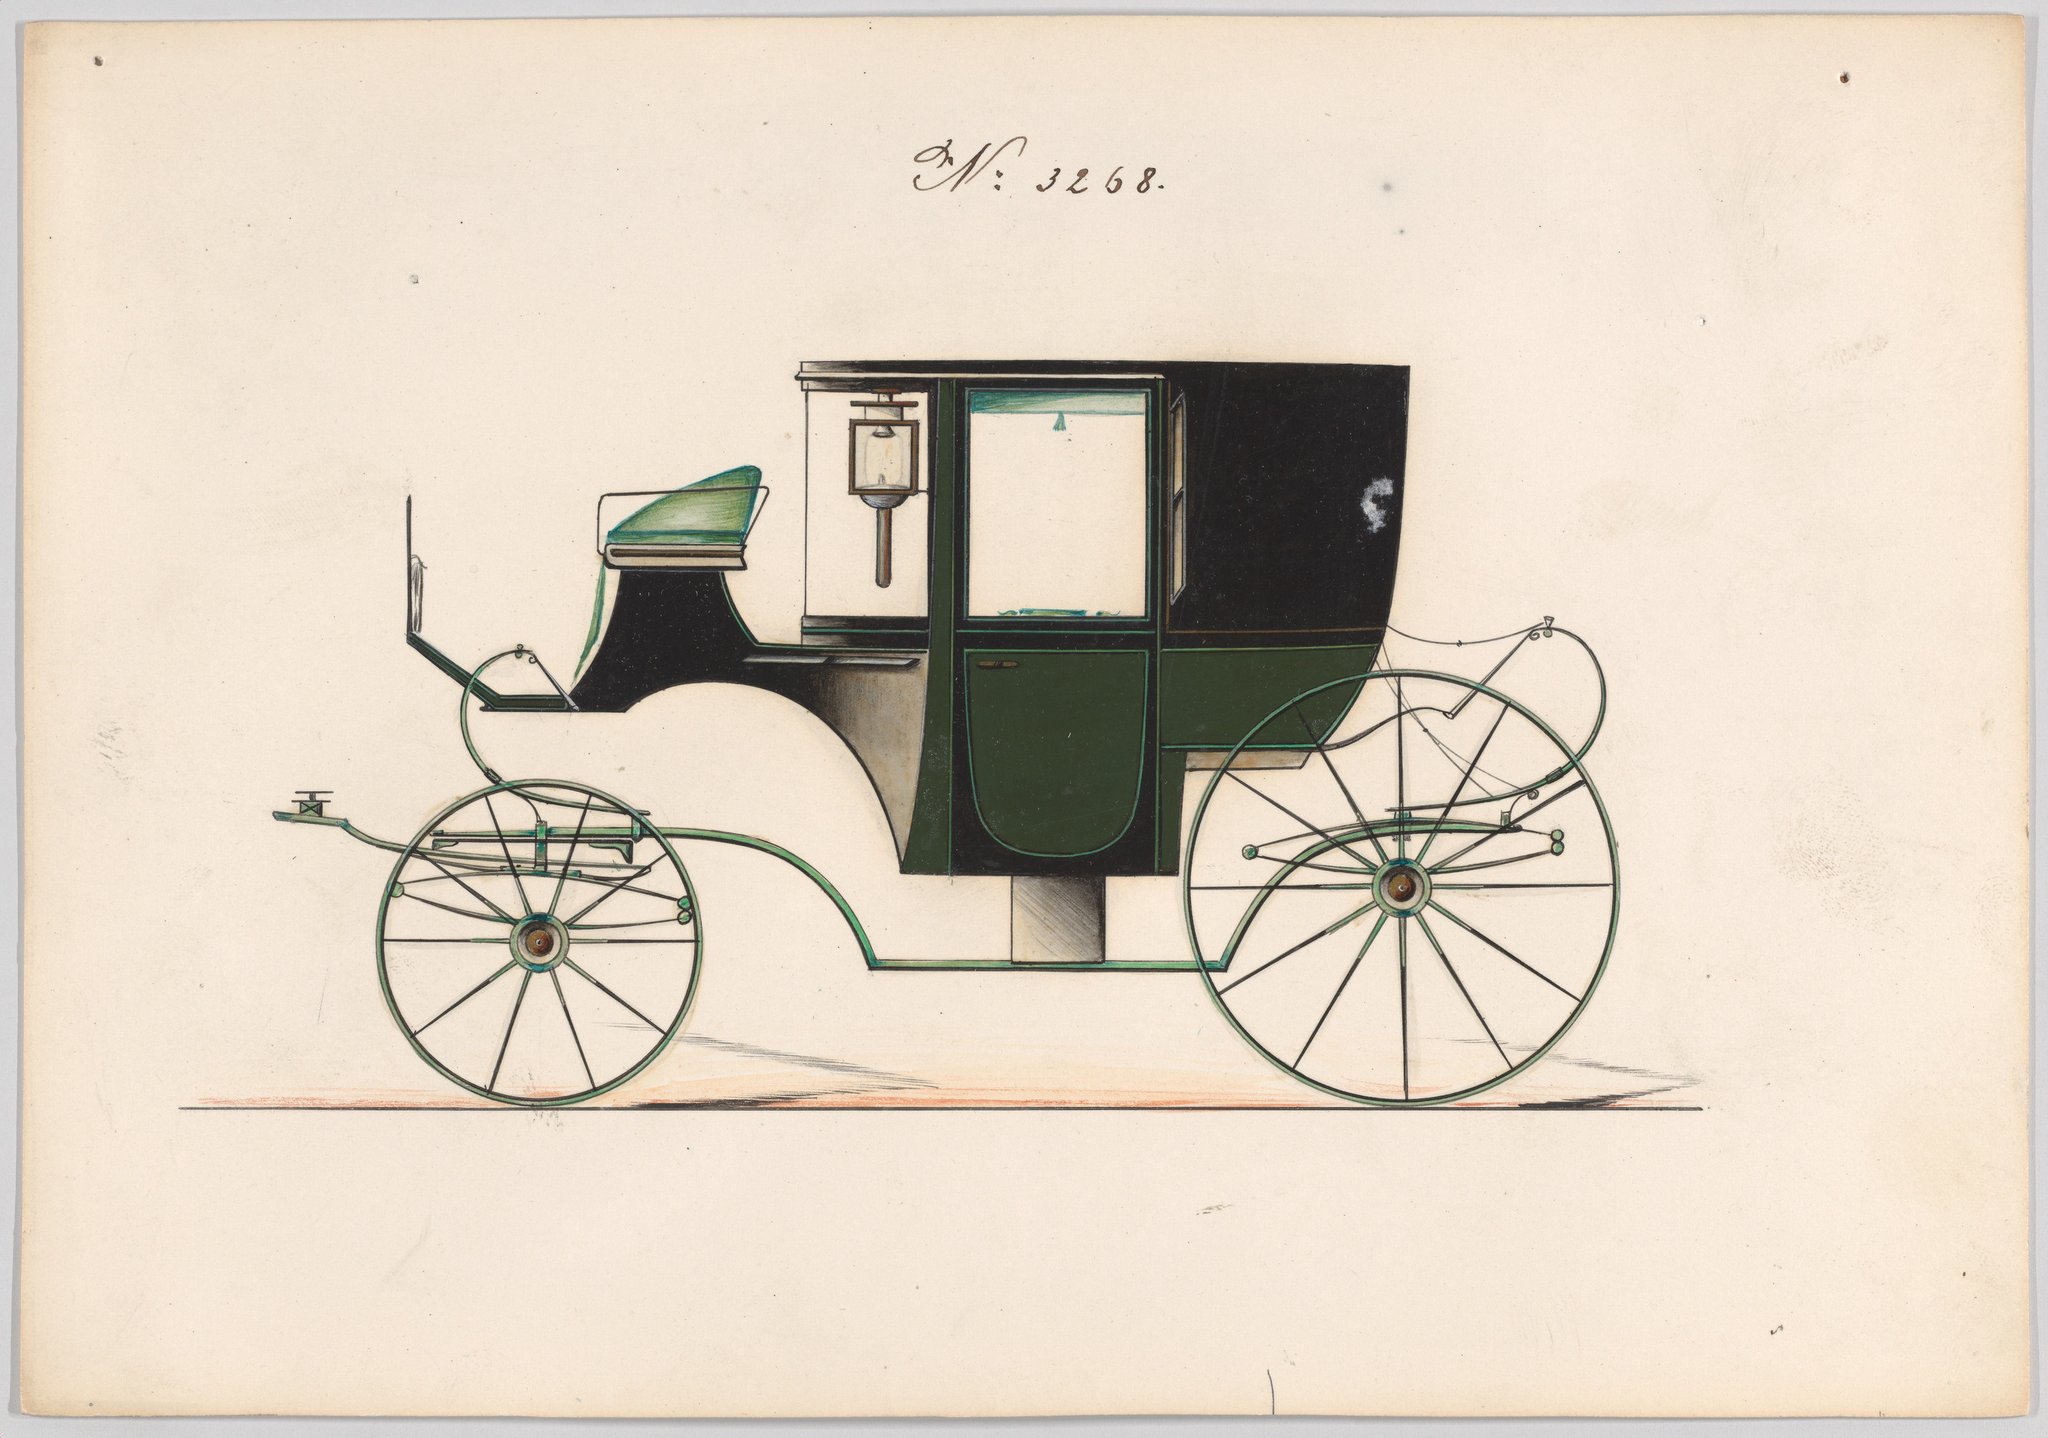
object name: drawing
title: Design for Coupé, no. 3268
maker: brewster & co.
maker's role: manufacturer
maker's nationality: american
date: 1876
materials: gouache, gum arabic, ink, watercolor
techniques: pen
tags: carriages